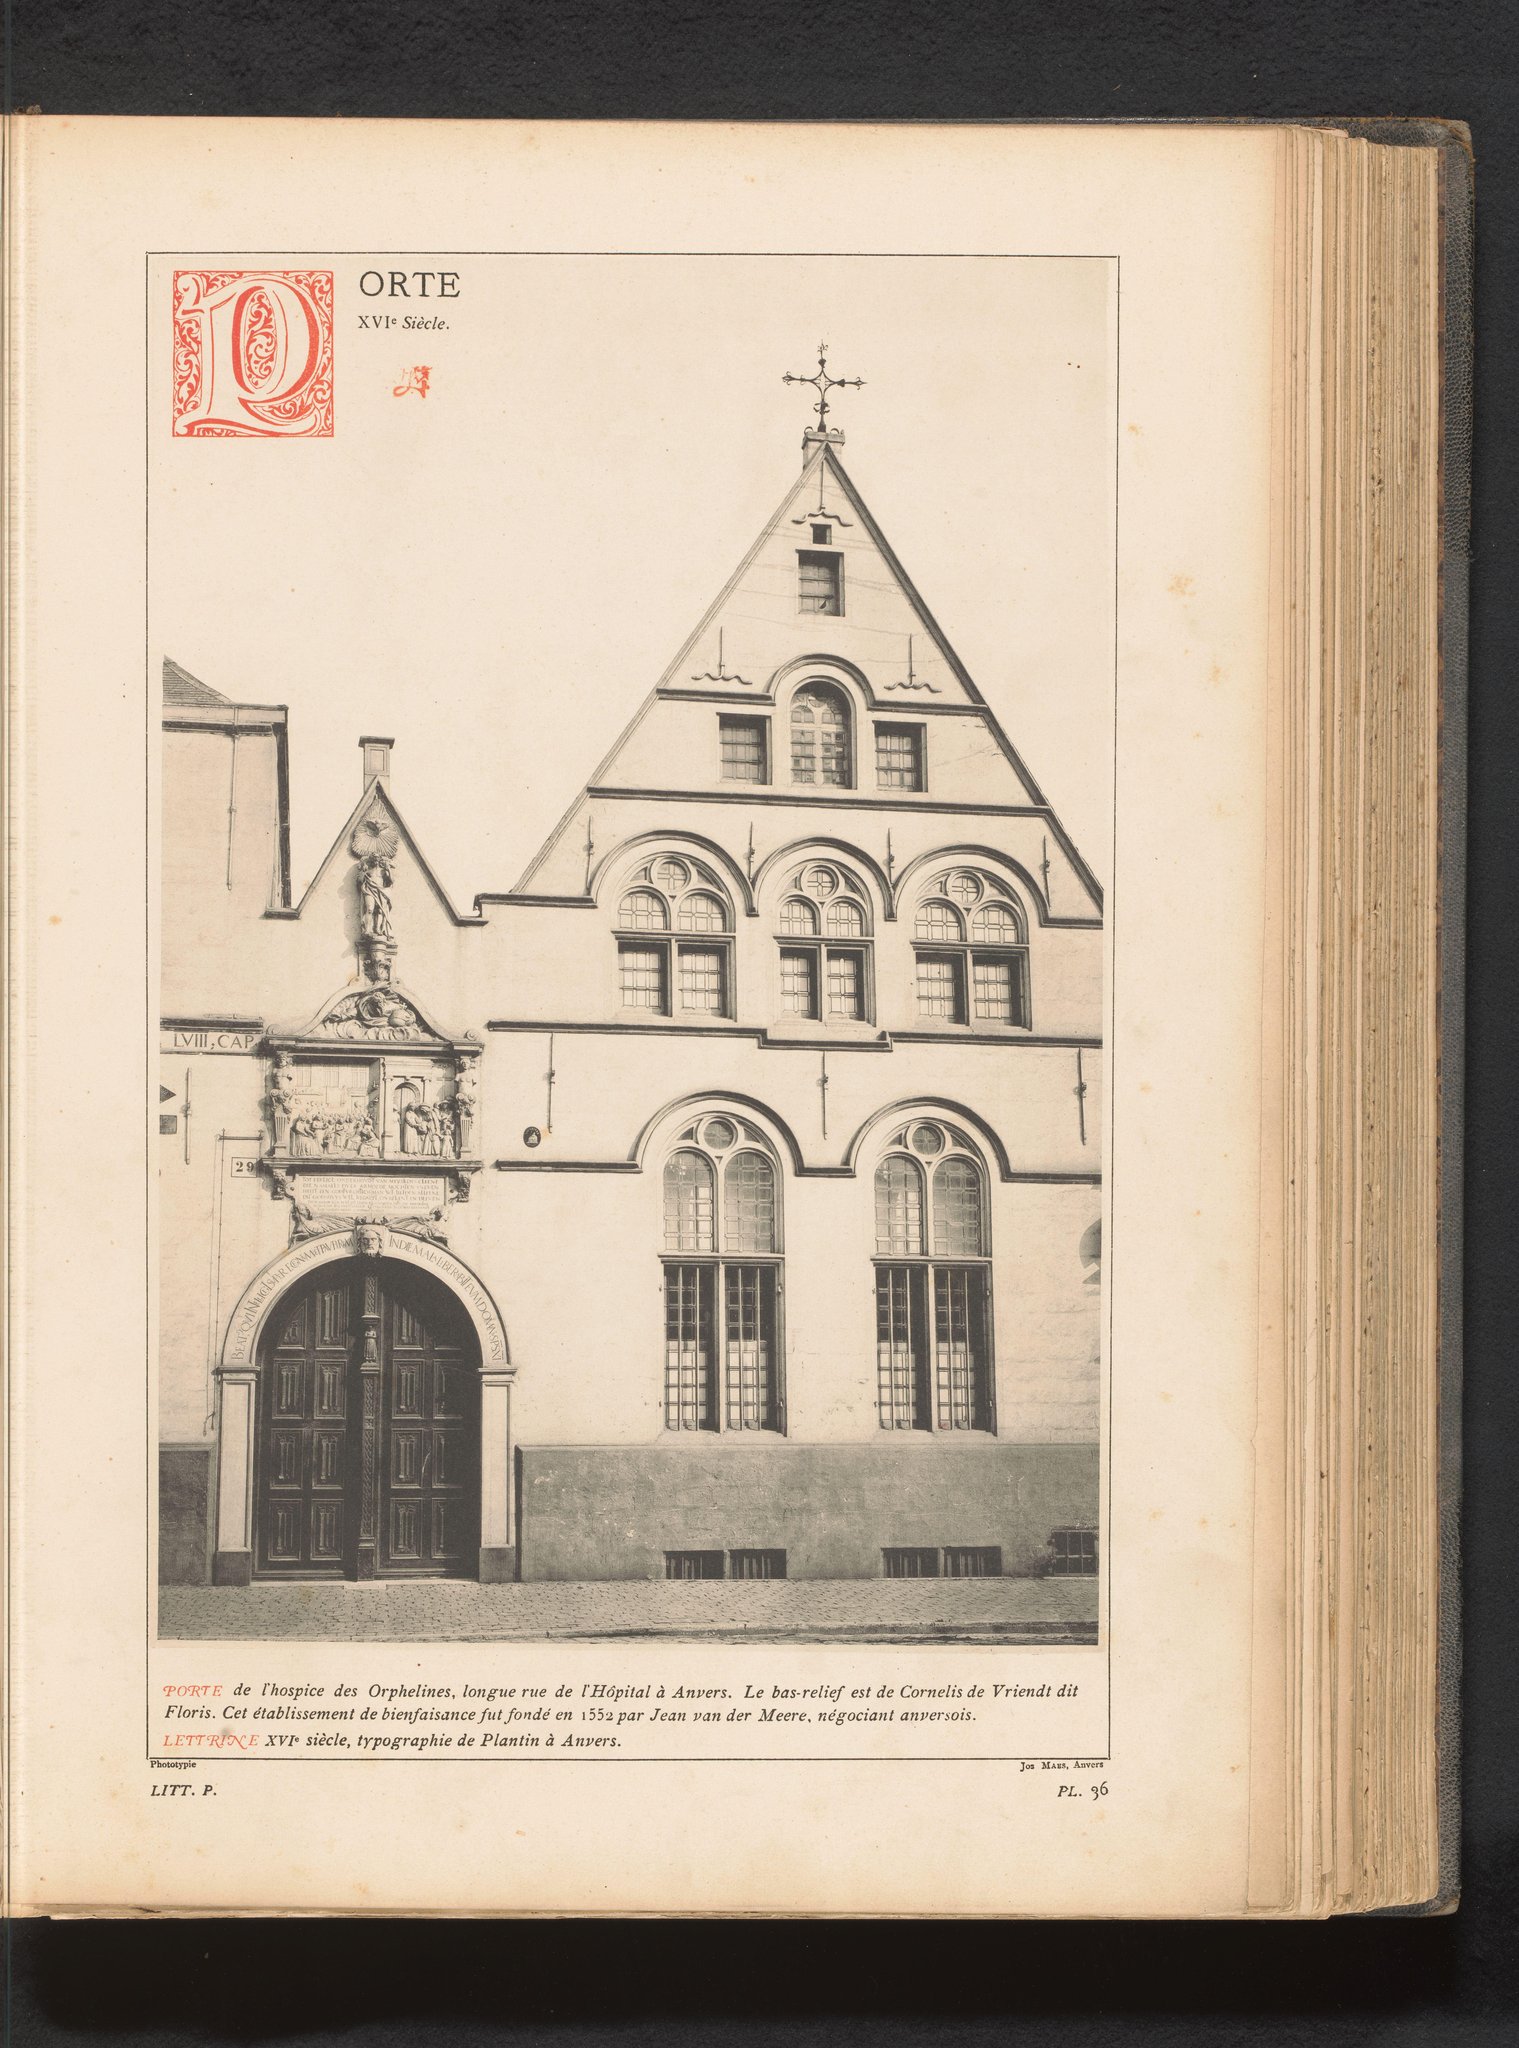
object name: page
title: Porte, XVIe Siècle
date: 1876-1881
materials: paper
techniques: photograph, photolithography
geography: antwerp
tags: civic architecture; edifices; dwellings, antwerp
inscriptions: monogram: ‘JJvY’, inscription: ‘LITT. P. - PL. 36.’, inscription: ‘PORTE de l'hospice (...)’